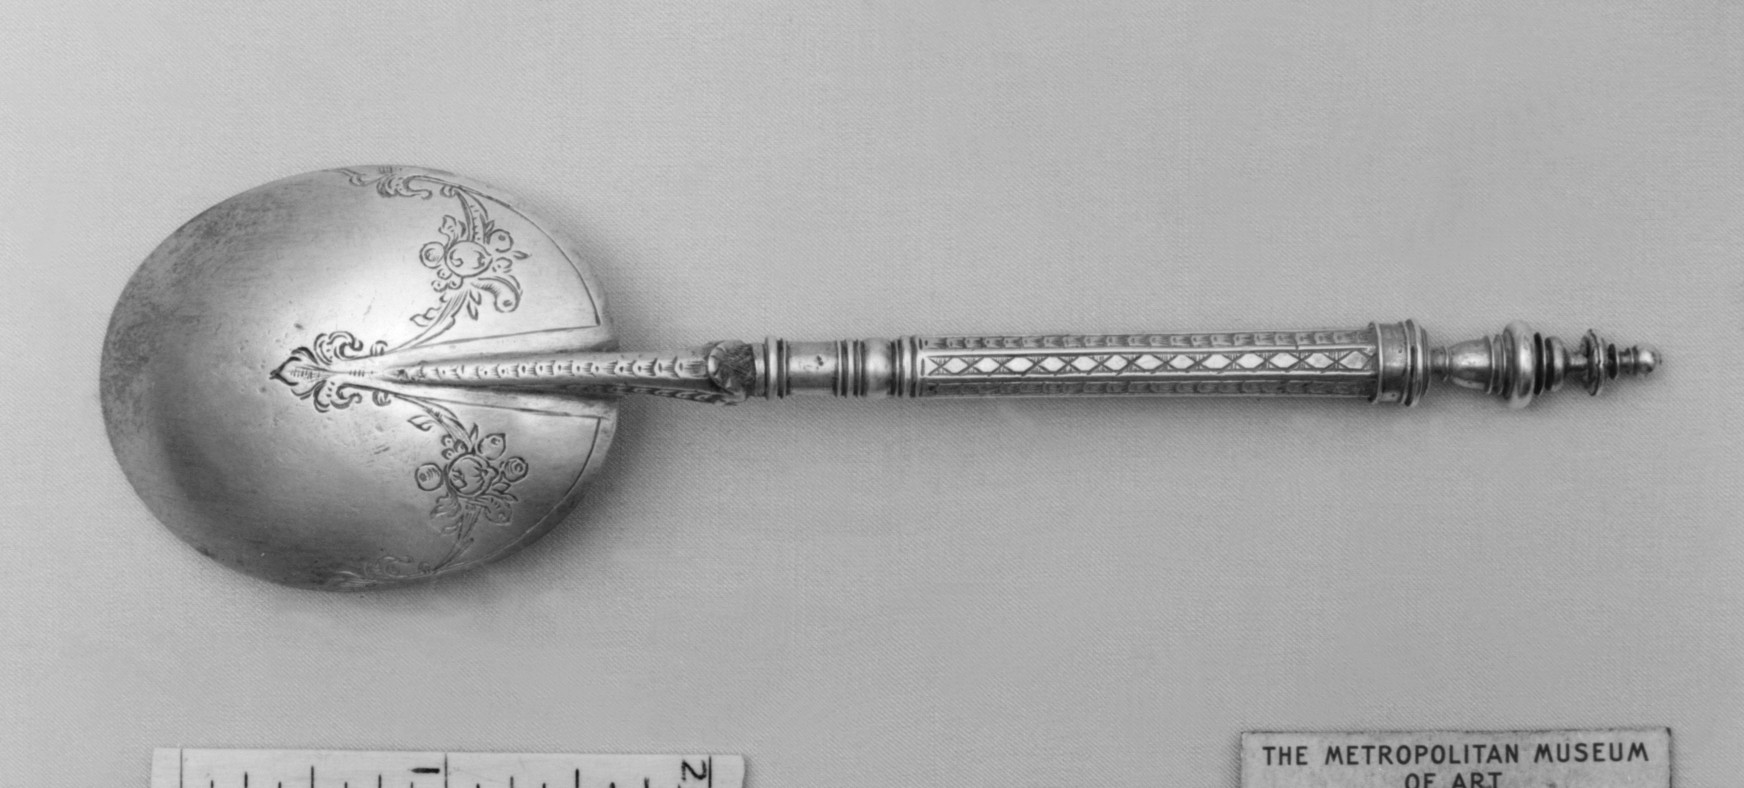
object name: spoon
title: Baluster top spoon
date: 1601-1700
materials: silver